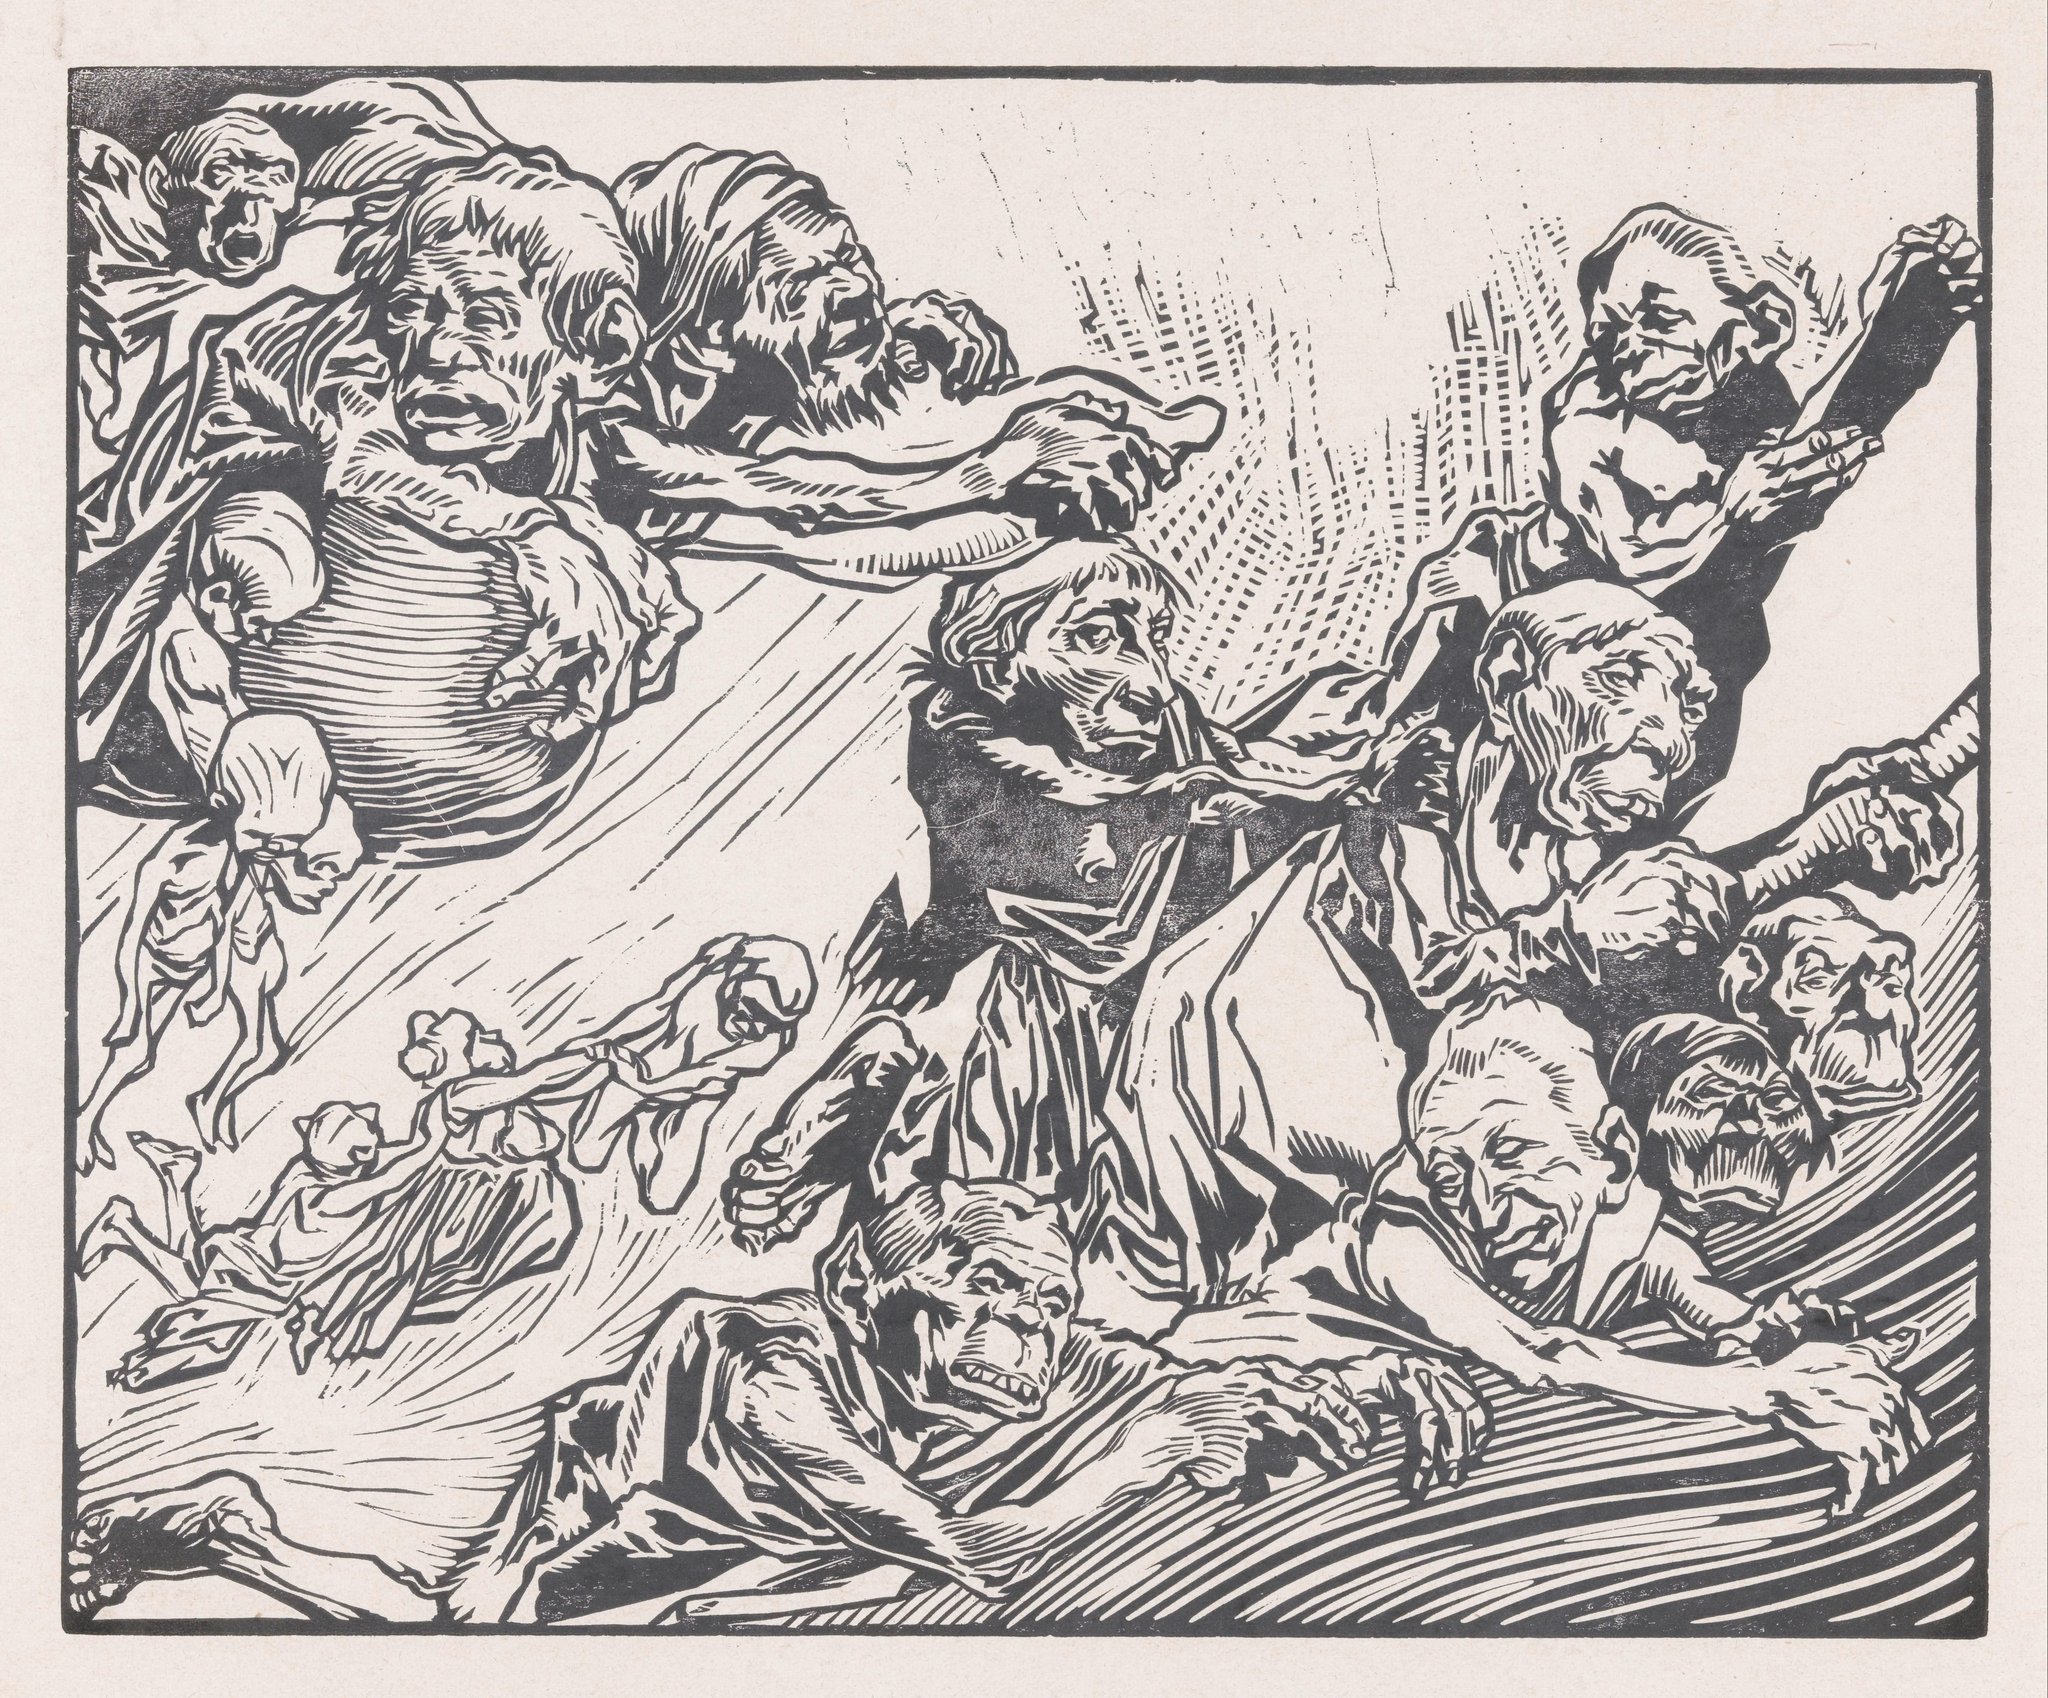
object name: print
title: Zwevende fantasiewezens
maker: johannes josephus aarts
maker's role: draughtsman, print maker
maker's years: 1871-1934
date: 1881-1934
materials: paper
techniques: woodcut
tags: movement in the air, surrealia, surrealistic representations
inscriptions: collector's mark: Lugt 2166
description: Verschillende groepen fantasiewezens bewegen zich voort door de lucht.